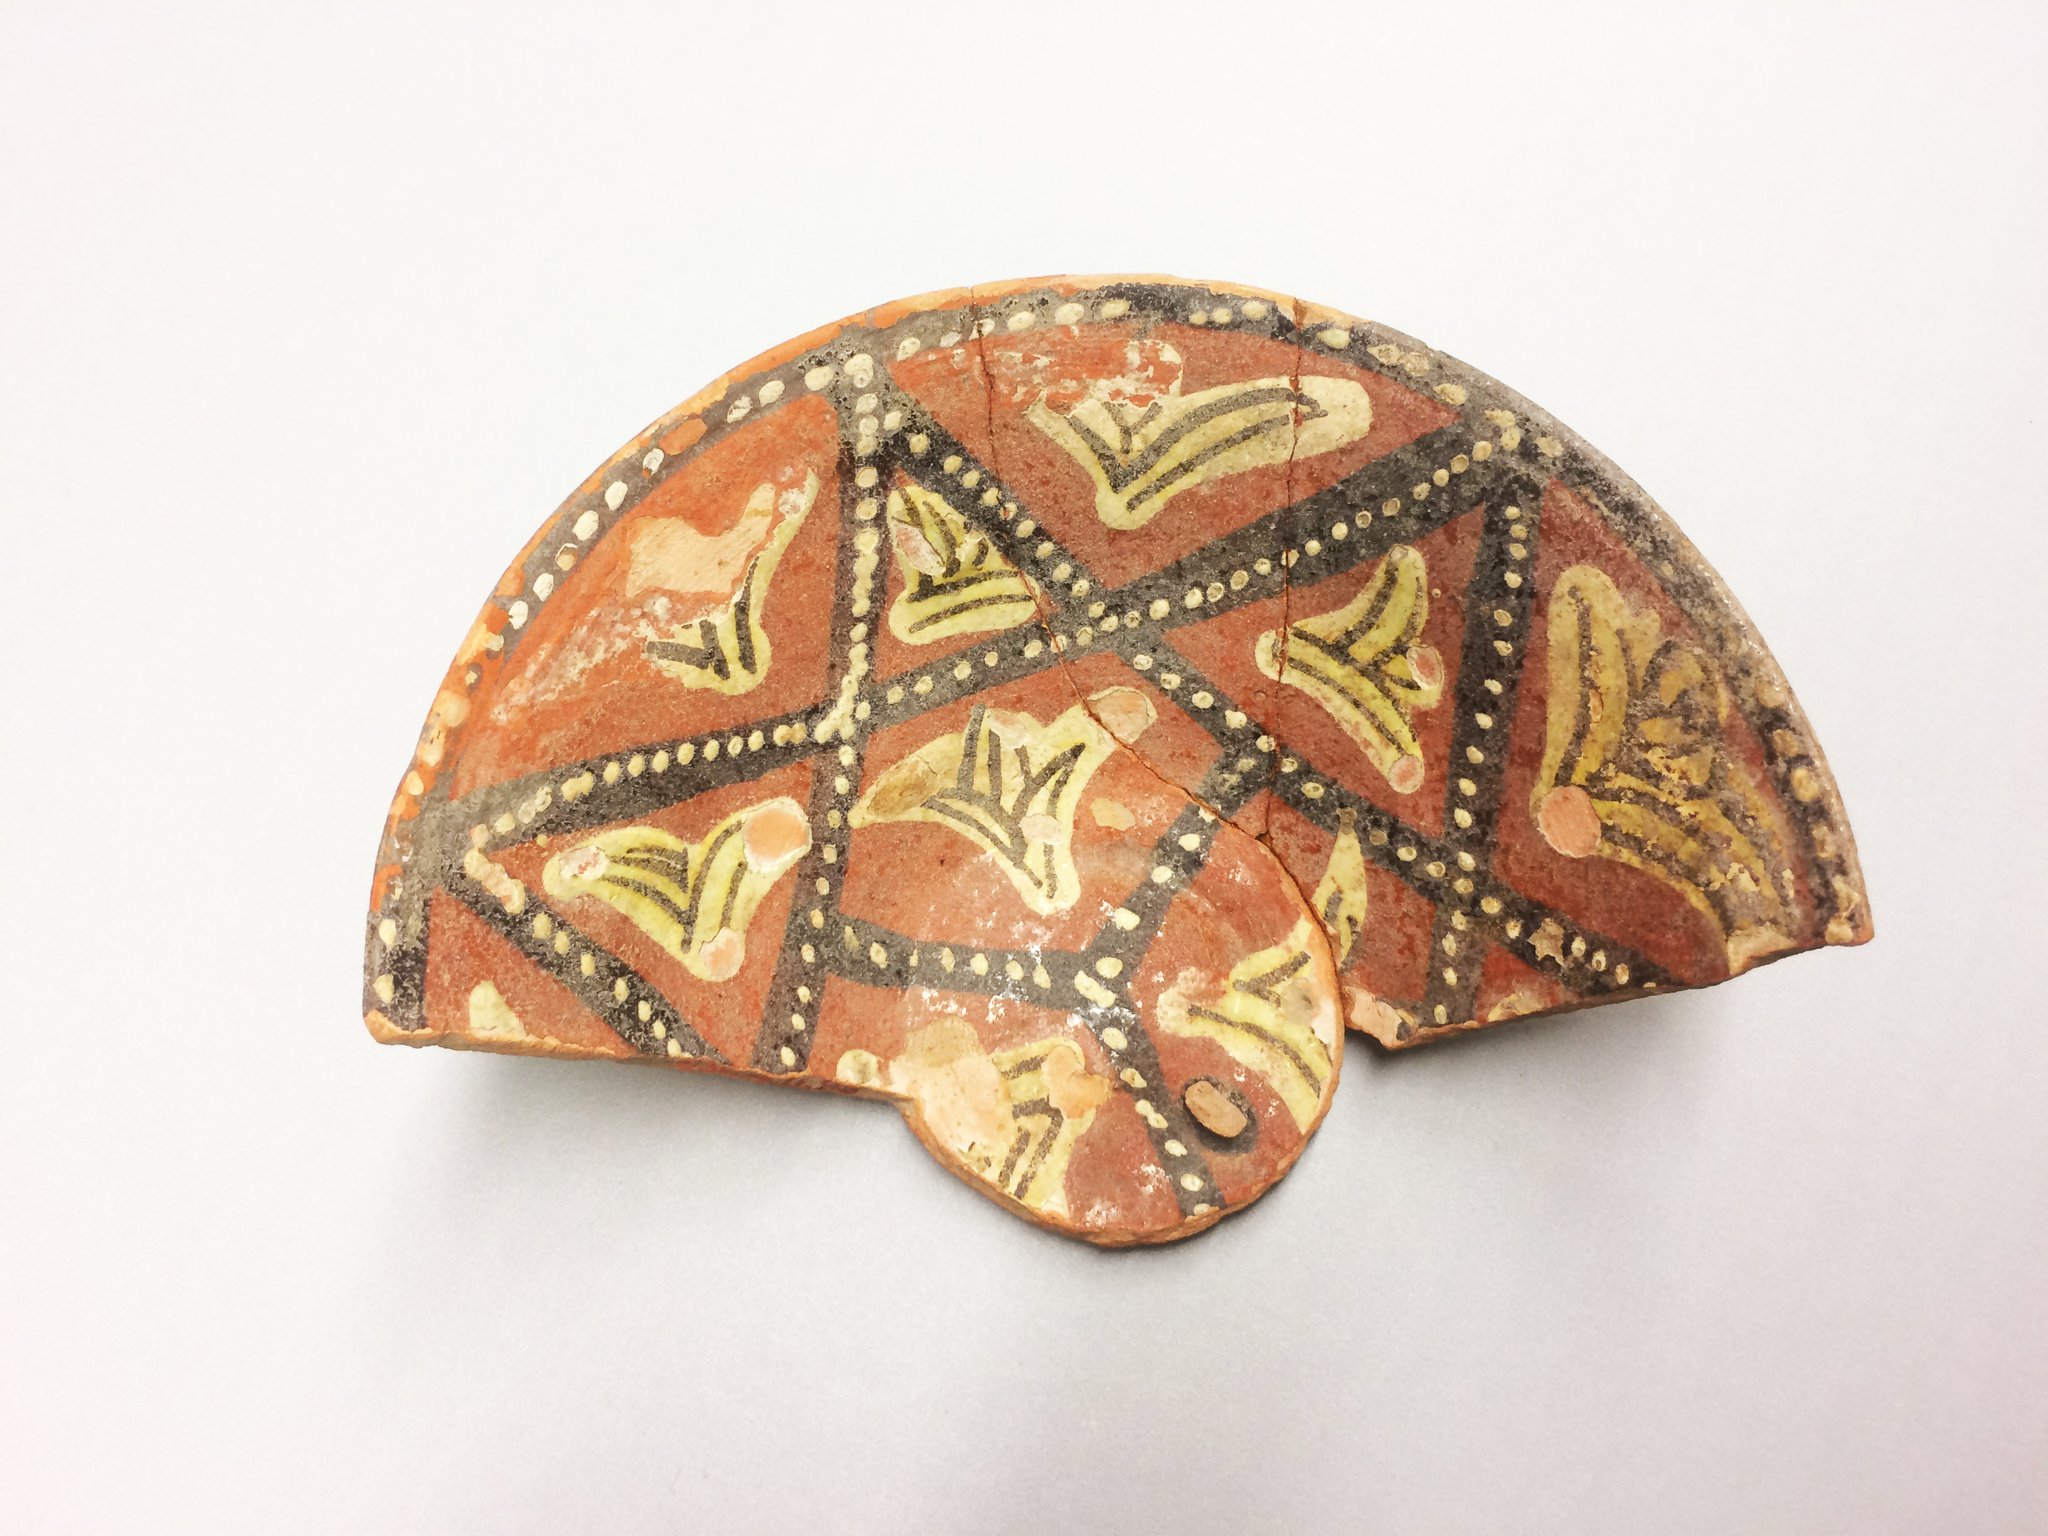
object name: fragment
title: Fragment of a Bowl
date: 801-1000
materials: earthenware, glaze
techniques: polychrome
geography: iran